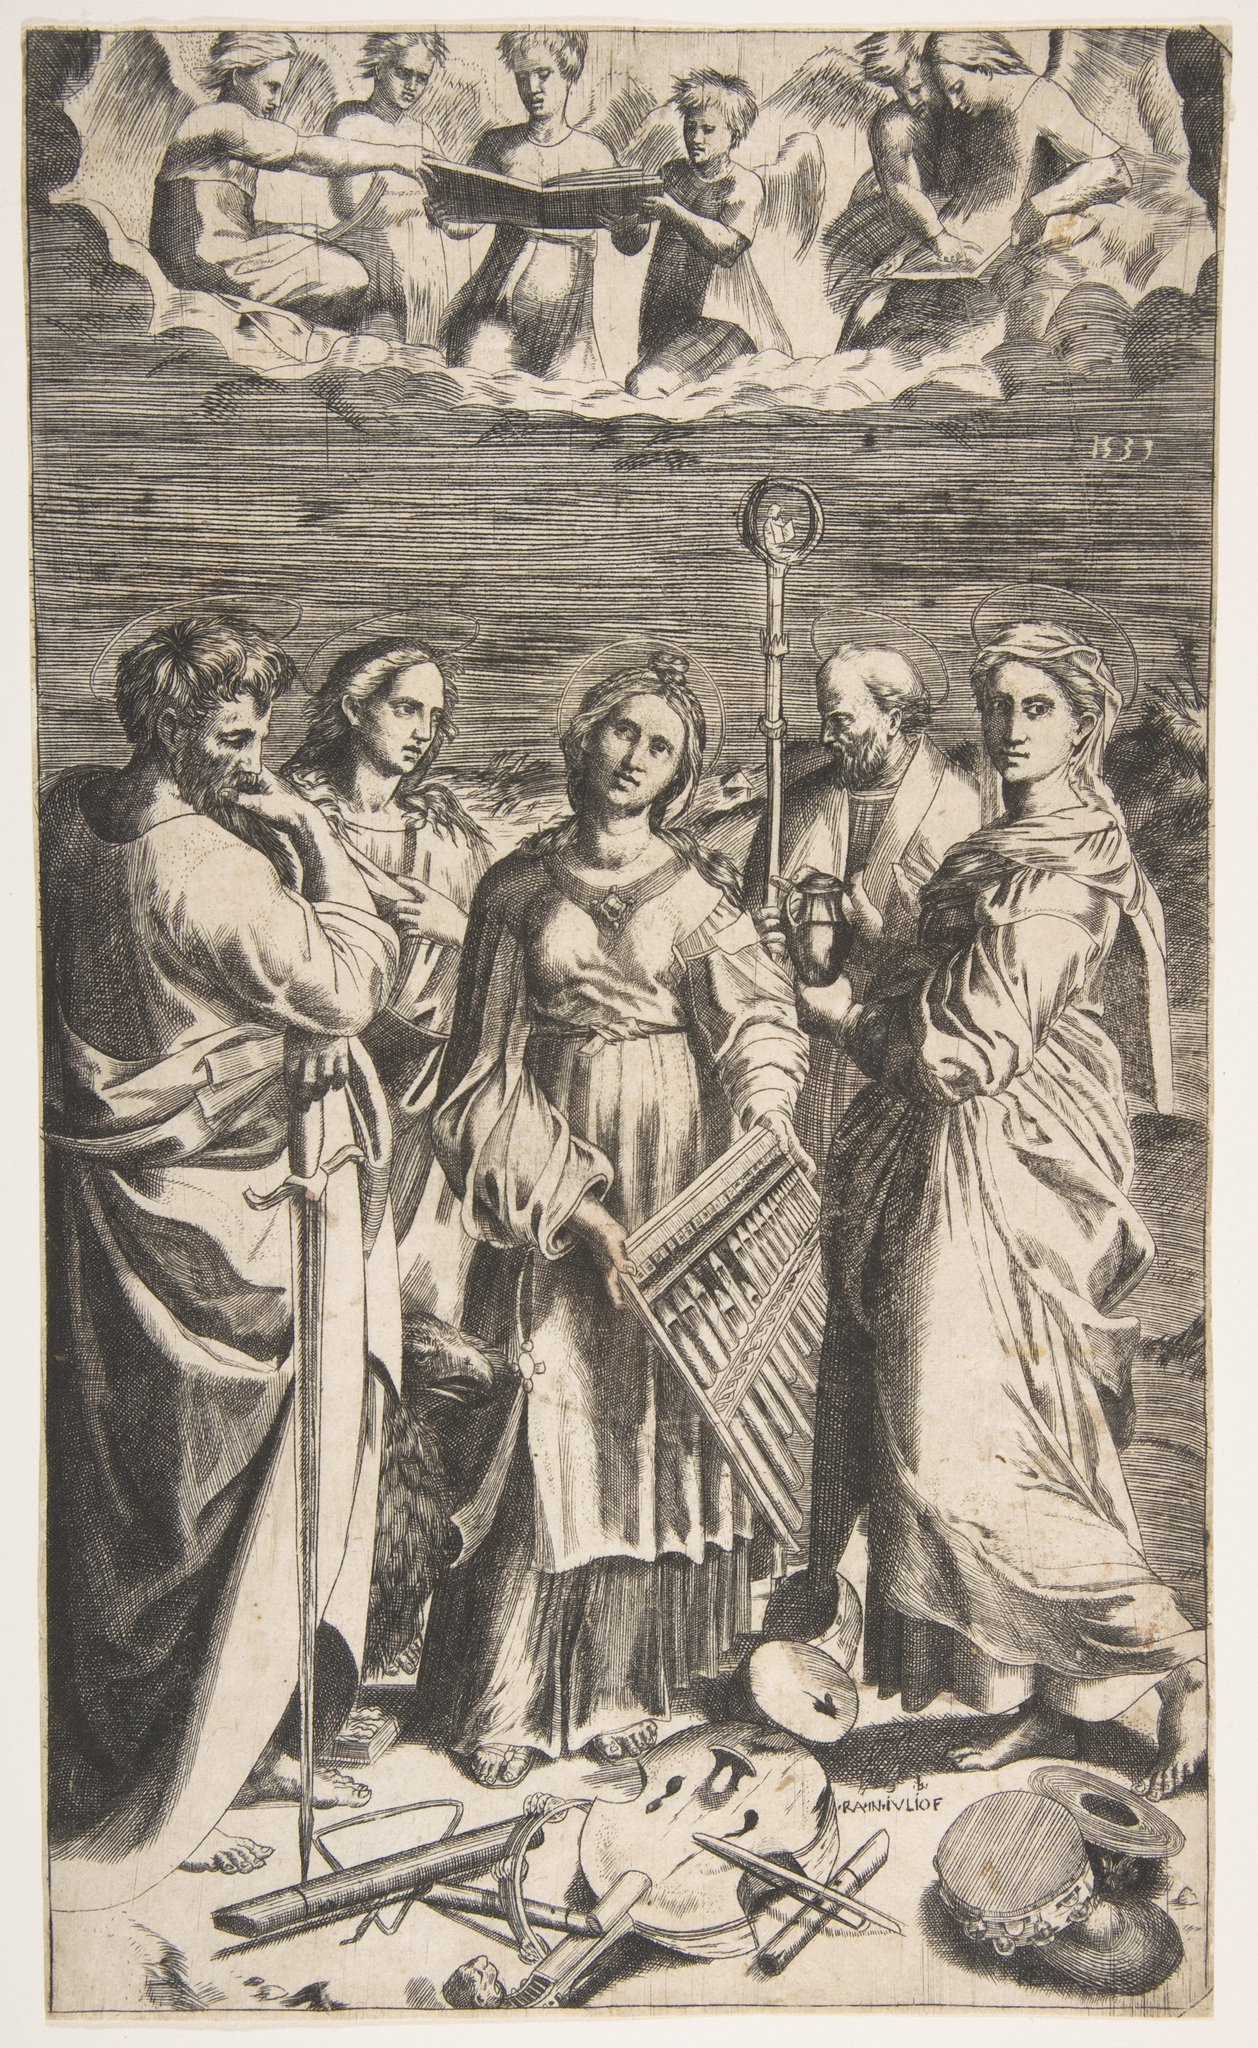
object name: print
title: Saint Cecilia standing in the centre accompanied by Saint Paul, the Magdalene, Saint John the Evangelist, and Saint Augustine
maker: giulio bonasone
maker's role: artist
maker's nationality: italian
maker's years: 1510-1576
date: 1531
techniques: engraving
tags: angels,mary magdalene,saint john the evangelist,saint paul,saints